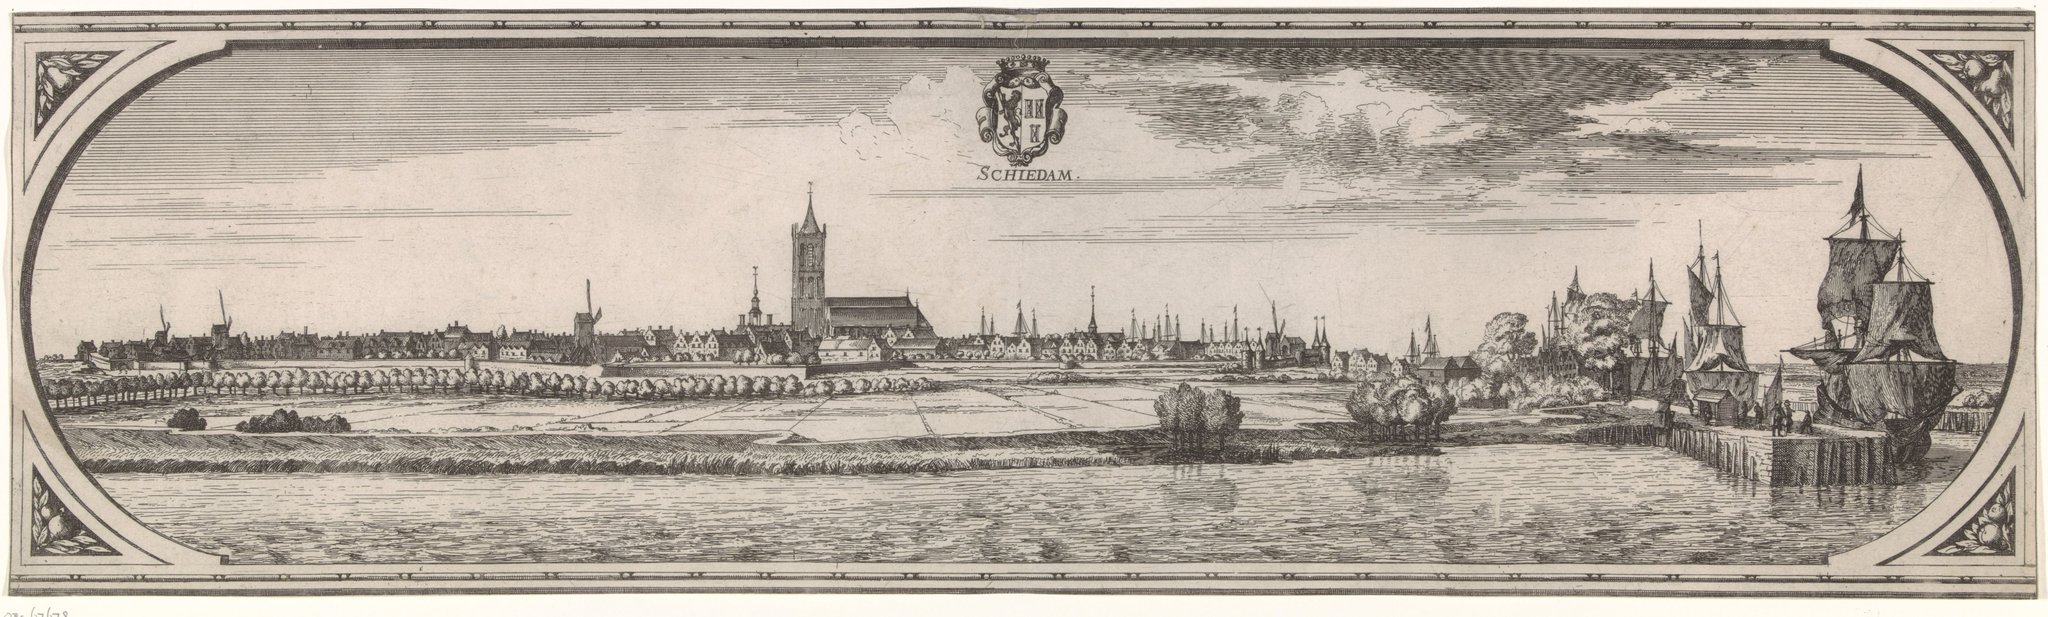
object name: print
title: Gezicht op Schiedam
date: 1666-1698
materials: paper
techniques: etching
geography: rotterdam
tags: coat of arms (as symbol of the state, etc.) (+ city; municipal), sailing-ship, sailing-boat, church (exterior), windmill, prospect of city, town panorama, silhouette of city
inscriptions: collector's mark: Lugt 2228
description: Gezicht op Schiedam gezien vanaf het water. In het midden de Sint-Janskerk. Rechts enkele zeilschepen. Boven in het midden het wapen van de stad en de titel.